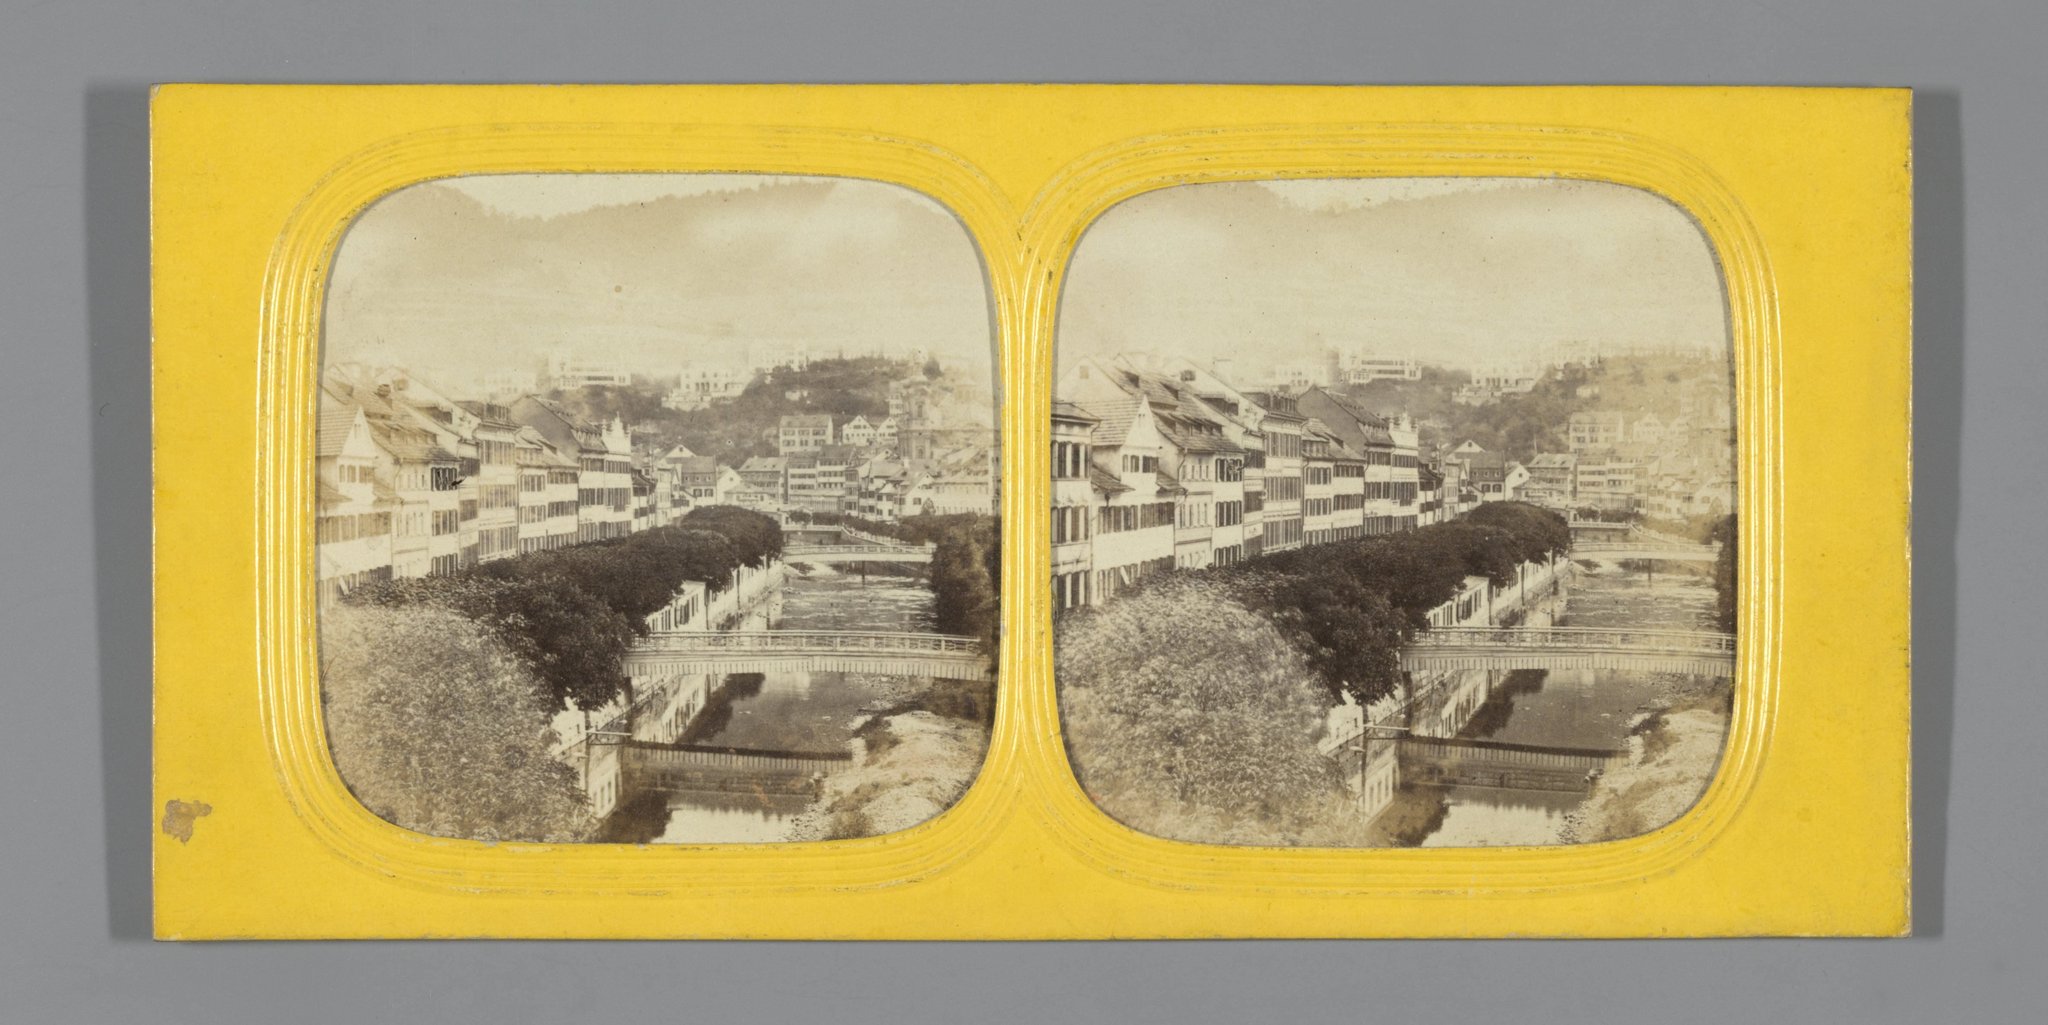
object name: tissue stereograph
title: Gezicht op rivier in een stad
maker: Anonymous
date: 1855-1875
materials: cardboard, paper, photographic support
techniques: albumen print, cutting, hand coloring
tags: bridge in city across river, canal, etc.